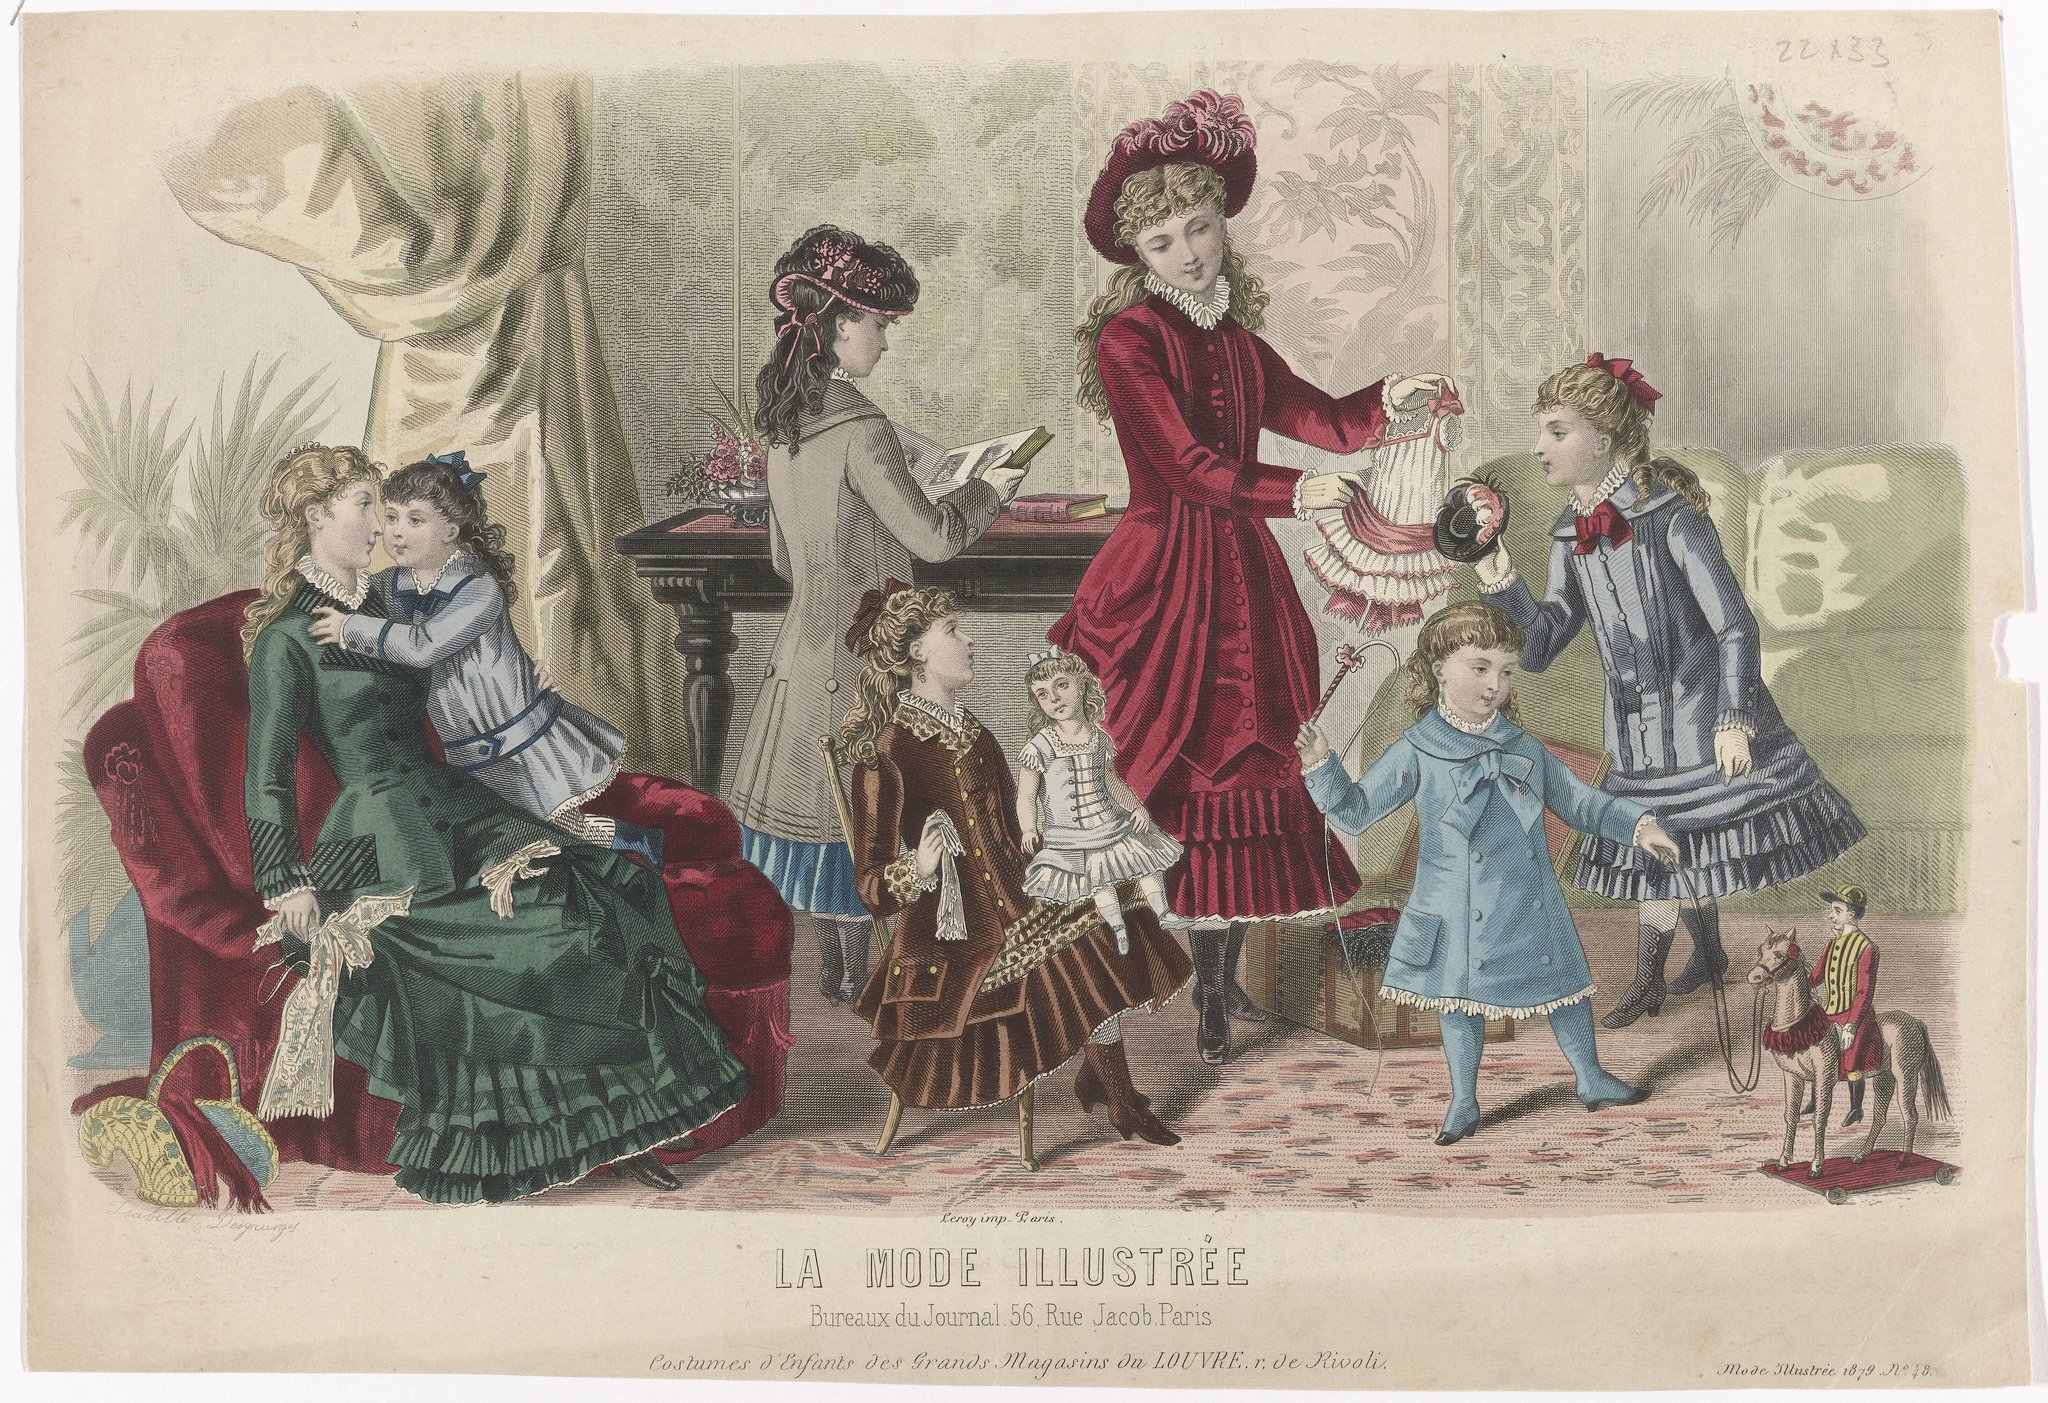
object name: fashion print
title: La Mode Illustrée, 1879, No. 48 : Costumes d'Enfants (...)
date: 1879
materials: paper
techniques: engraving, hand coloring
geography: paris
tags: head-gear (+ girls' clothes), boots (+ girls' clothes), doll's clothes, coat (+ girls' clothes), hobby-horse, fashion plates, book - mm - book open, (playing with) dolls, dress, gown (+ girls' clothes), whip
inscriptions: address: ‘Bureaux du journal, 56, rue Jacob Paris’, caption: ‘Costumes d'Enfants des Grands Magasins du Louvre, r. de Rivoli.’, title: ‘La Mode Illustrée’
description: Zeven meisjes in interieur, spelend met een pop, poppenkleren en trekpaard. Volgens het onderschrift is de kinderkleding van het warenhuis Grands Magasins du Louvre. Prent uit het modetijdschrift La Mode Illustrée (1860-1937).